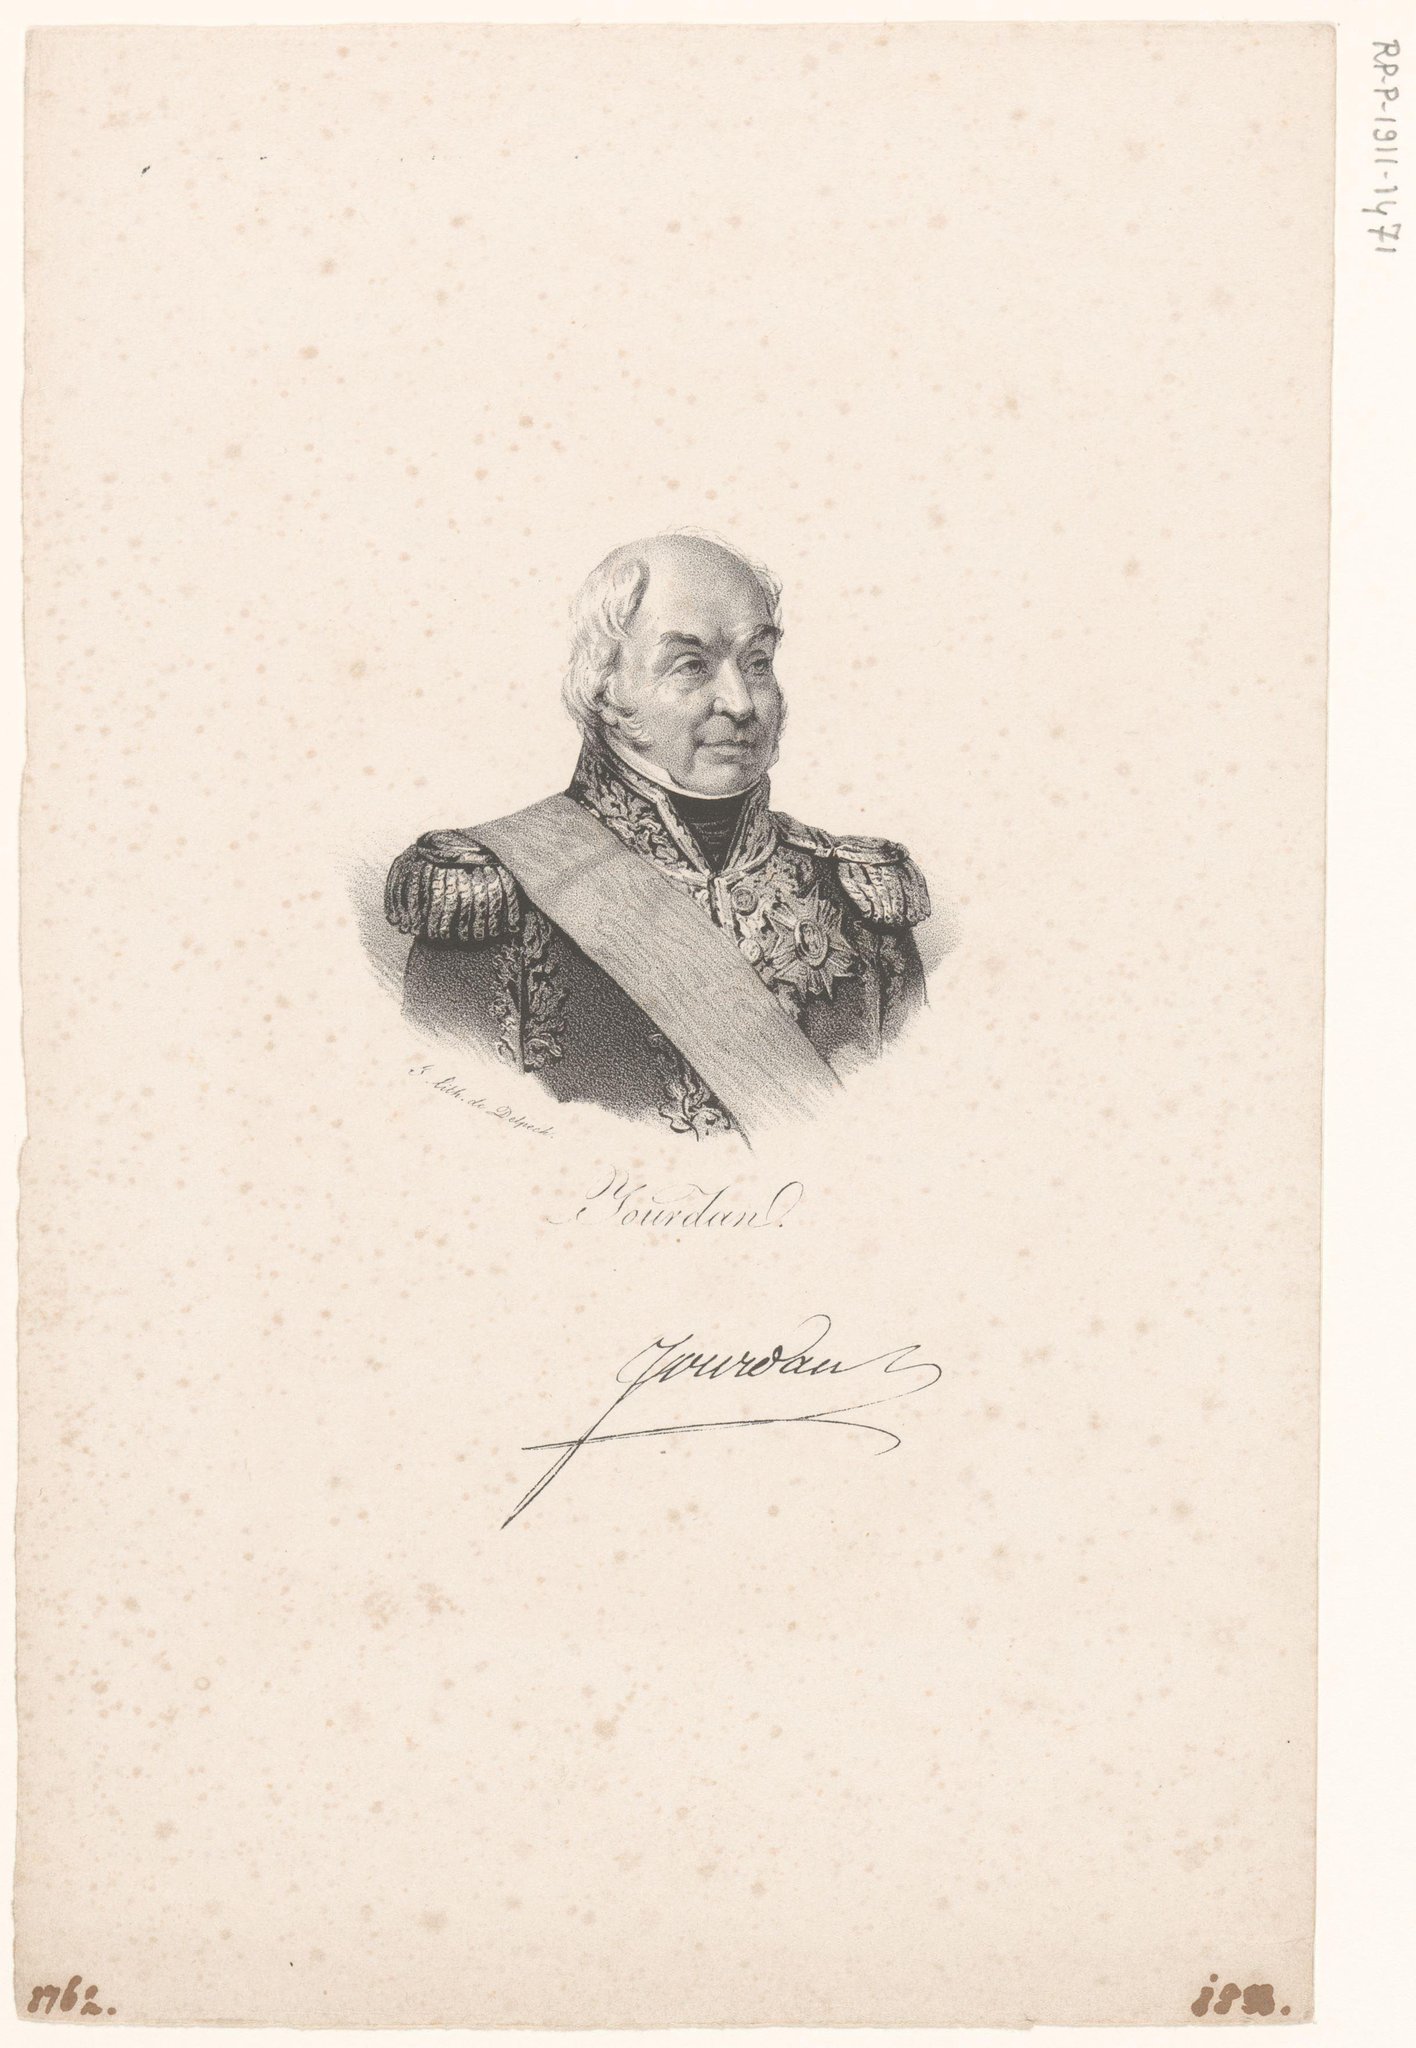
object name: print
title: Portret van Jean-Baptiste Jourdan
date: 1818-1842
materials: paper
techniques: lithograph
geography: paris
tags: historical persons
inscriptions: collector's mark: Lugt 2228a